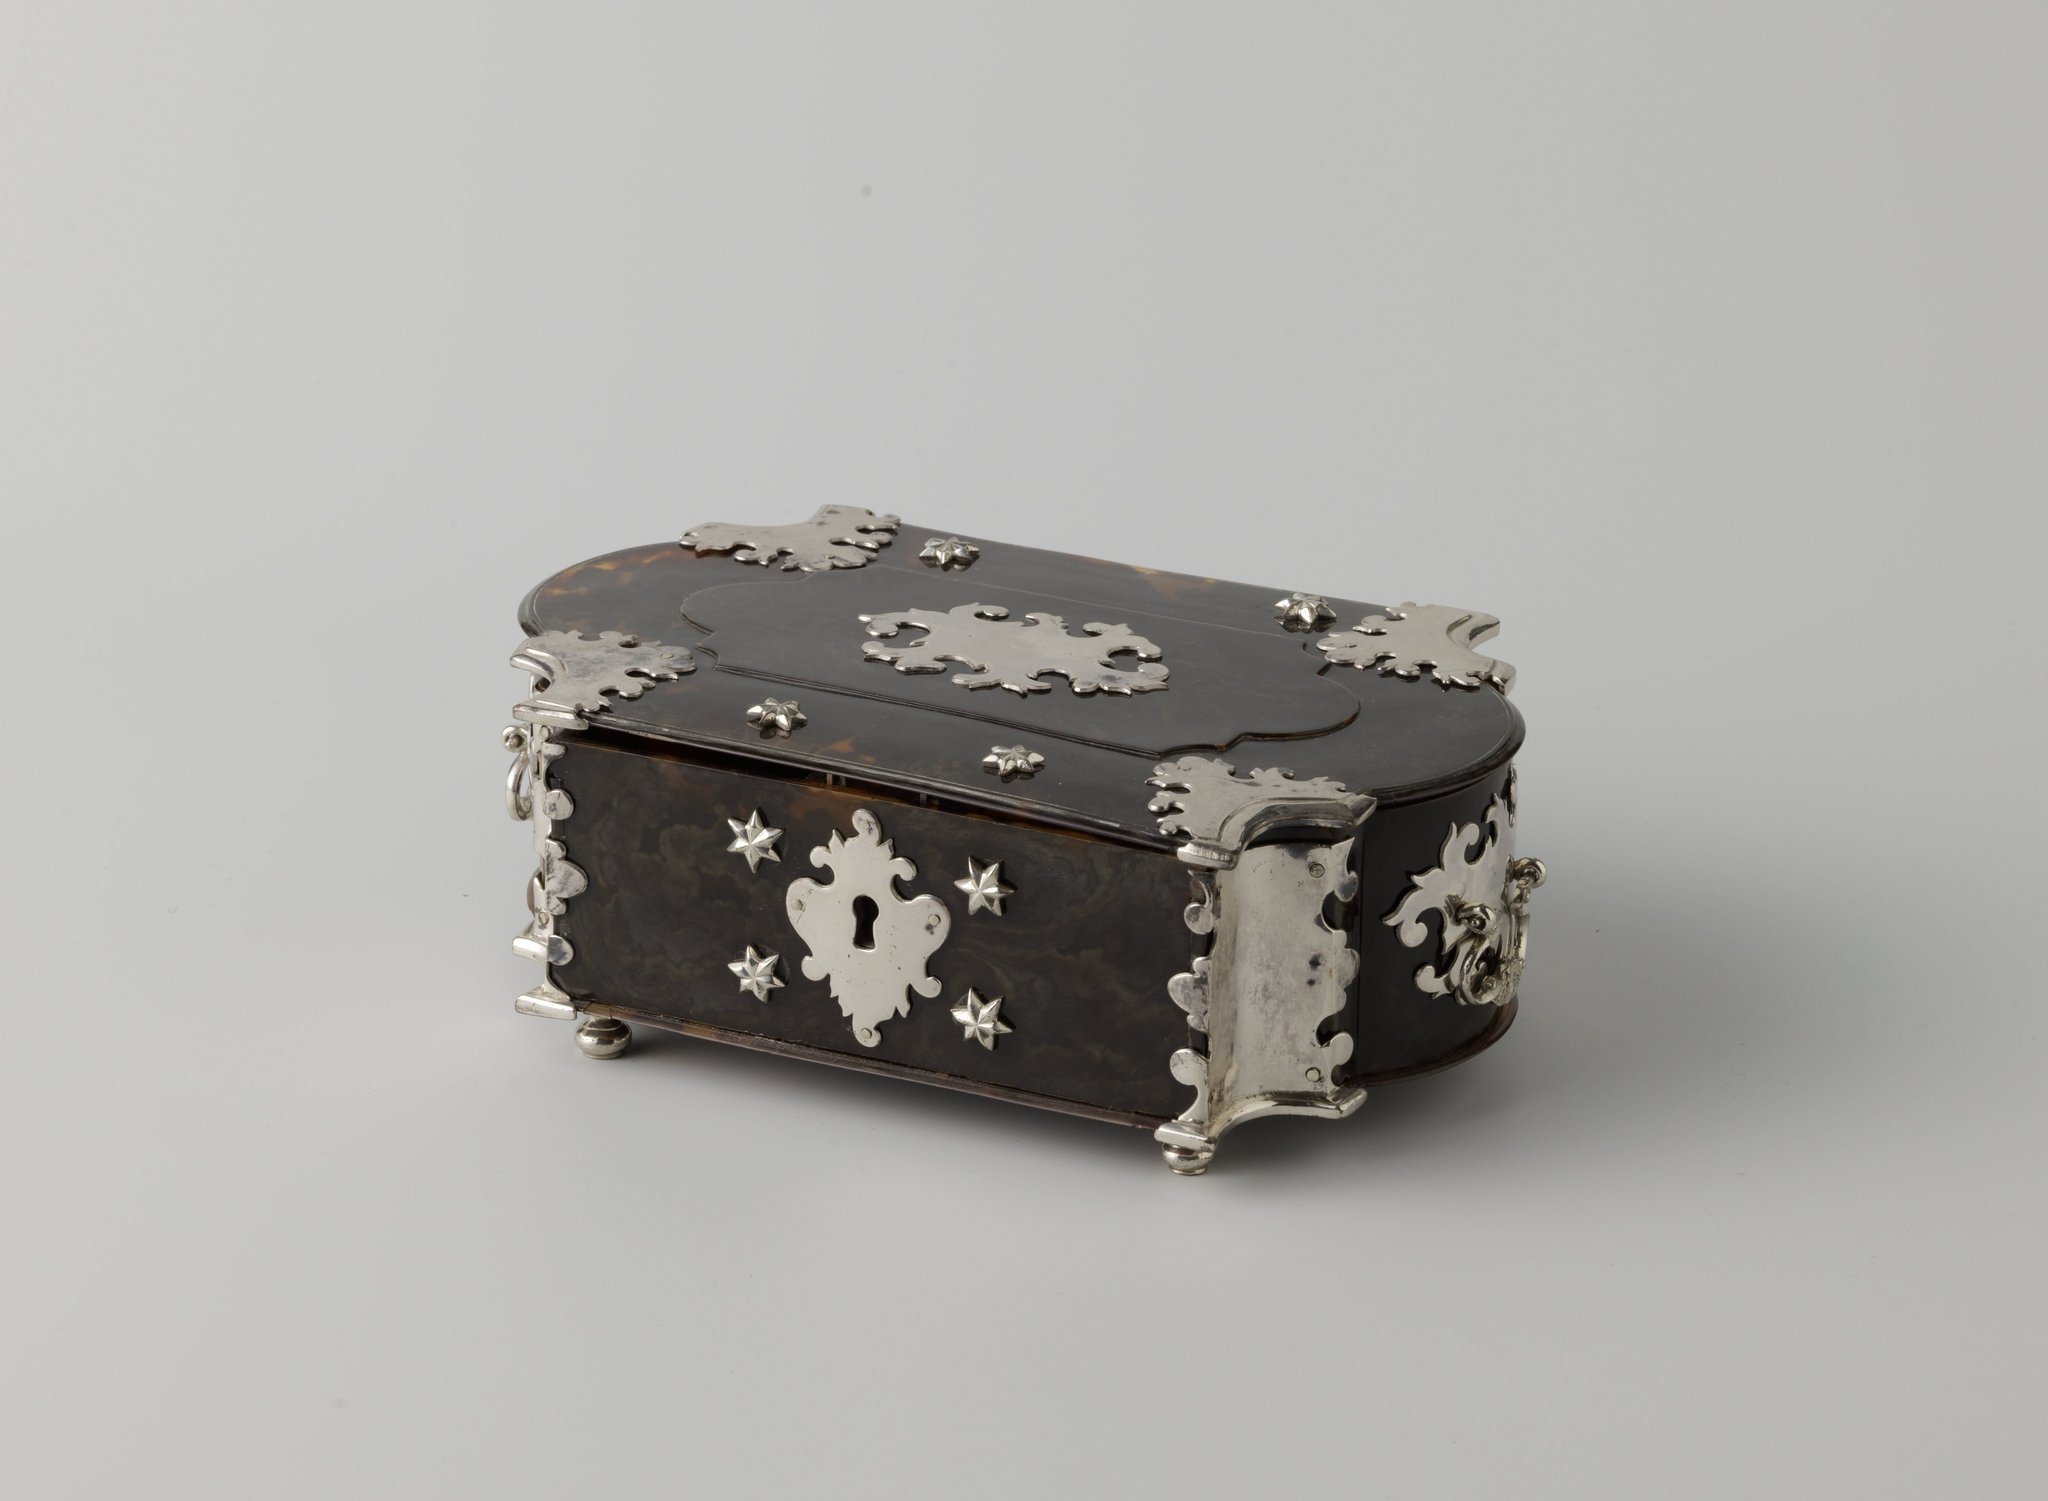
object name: chest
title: Kist, bekleed met schildpad, met beslag van zilver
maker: hendrik rennenbaum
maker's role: silversmith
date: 1740-1760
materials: silver, shell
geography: indonesia